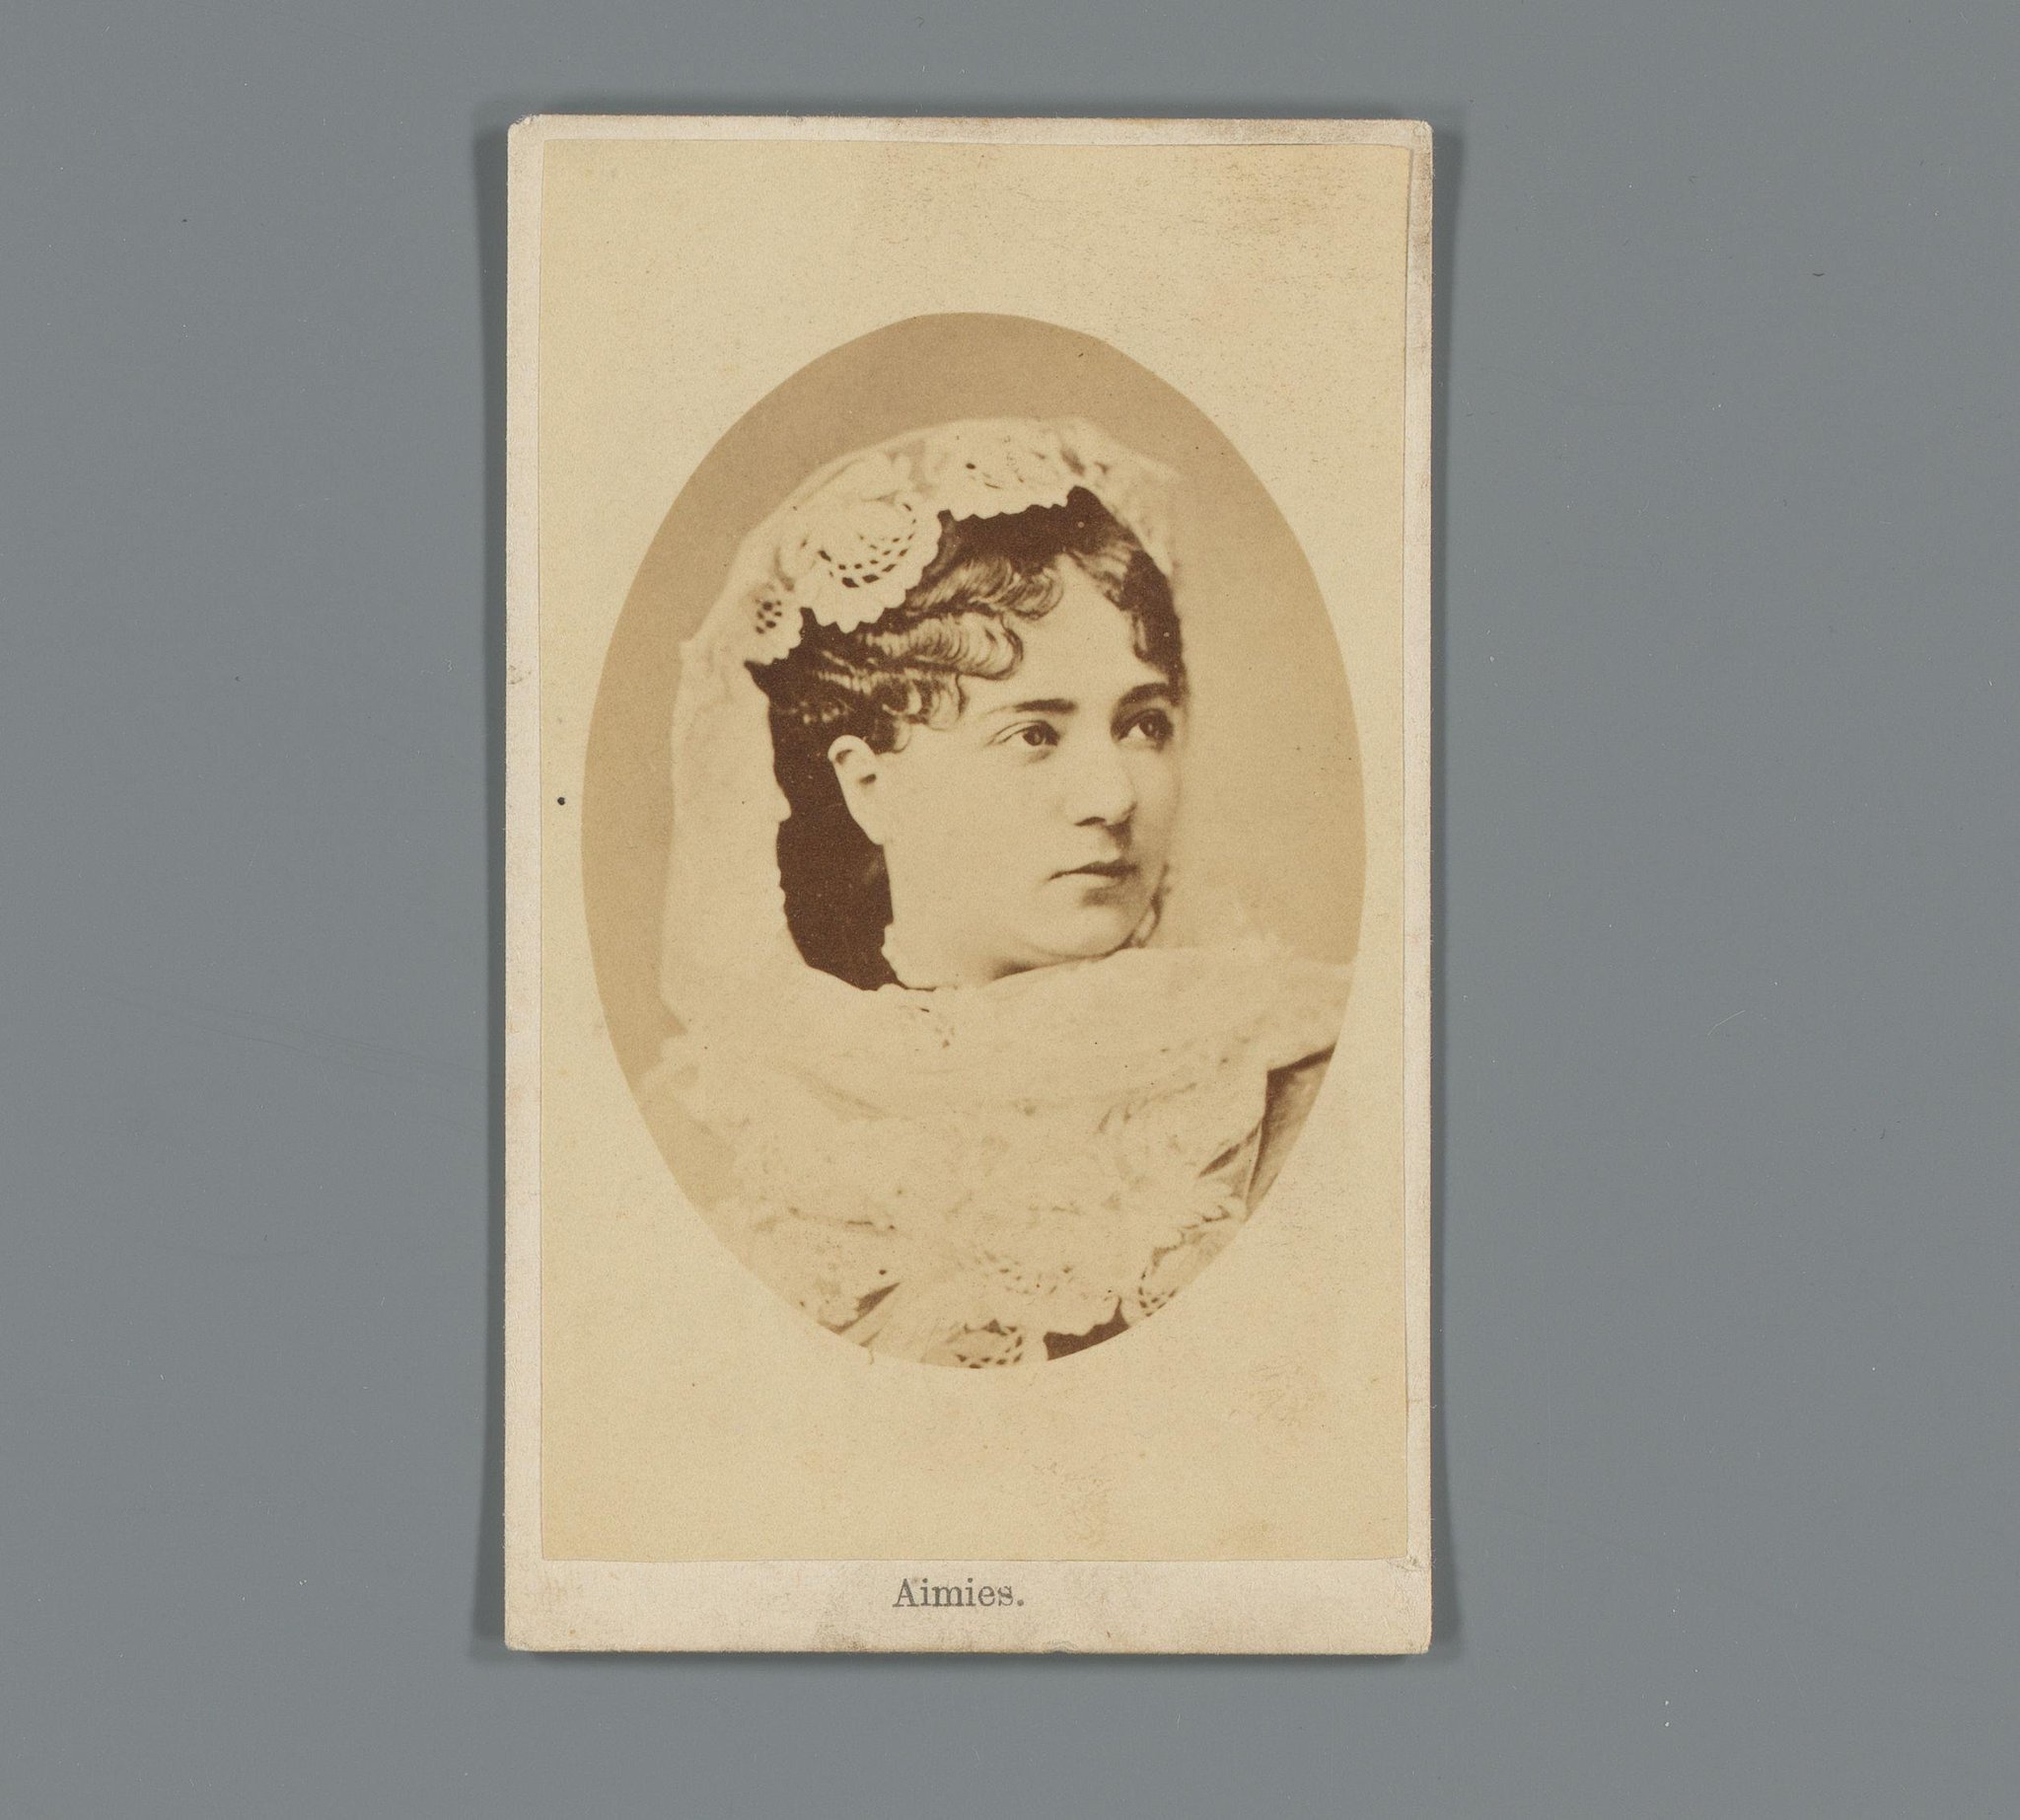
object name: photograph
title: Portret van een onbekende vrouw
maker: Anonymous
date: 1850-1915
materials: cardboard, photographic support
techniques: albumen print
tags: historical persons not known by name - bb - woman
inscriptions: inscription: ‘Aimies.’, inscription: ‘Dealers in BOOKS, STATIONERY./ SHEET MUSIC,/ CHROMOS, ENGRAVINGS,/ Picture Frames, Vases,/ TOILET SETS, TOYS,/ AND FANCY GOODS./ Can find a full assortment at and be-/ low New York prices,/ at the/ "BEEHIVE,"/ Cor. Main & Cannon Sts.,/ BRIDGEPORT, CT./ 20 Cents saved on every Dollar's/ Worth of SCHOOL BOOKS,/ or any other Books/ bought of us./ Send to S.C. NORTHROP for a Catalogue.’